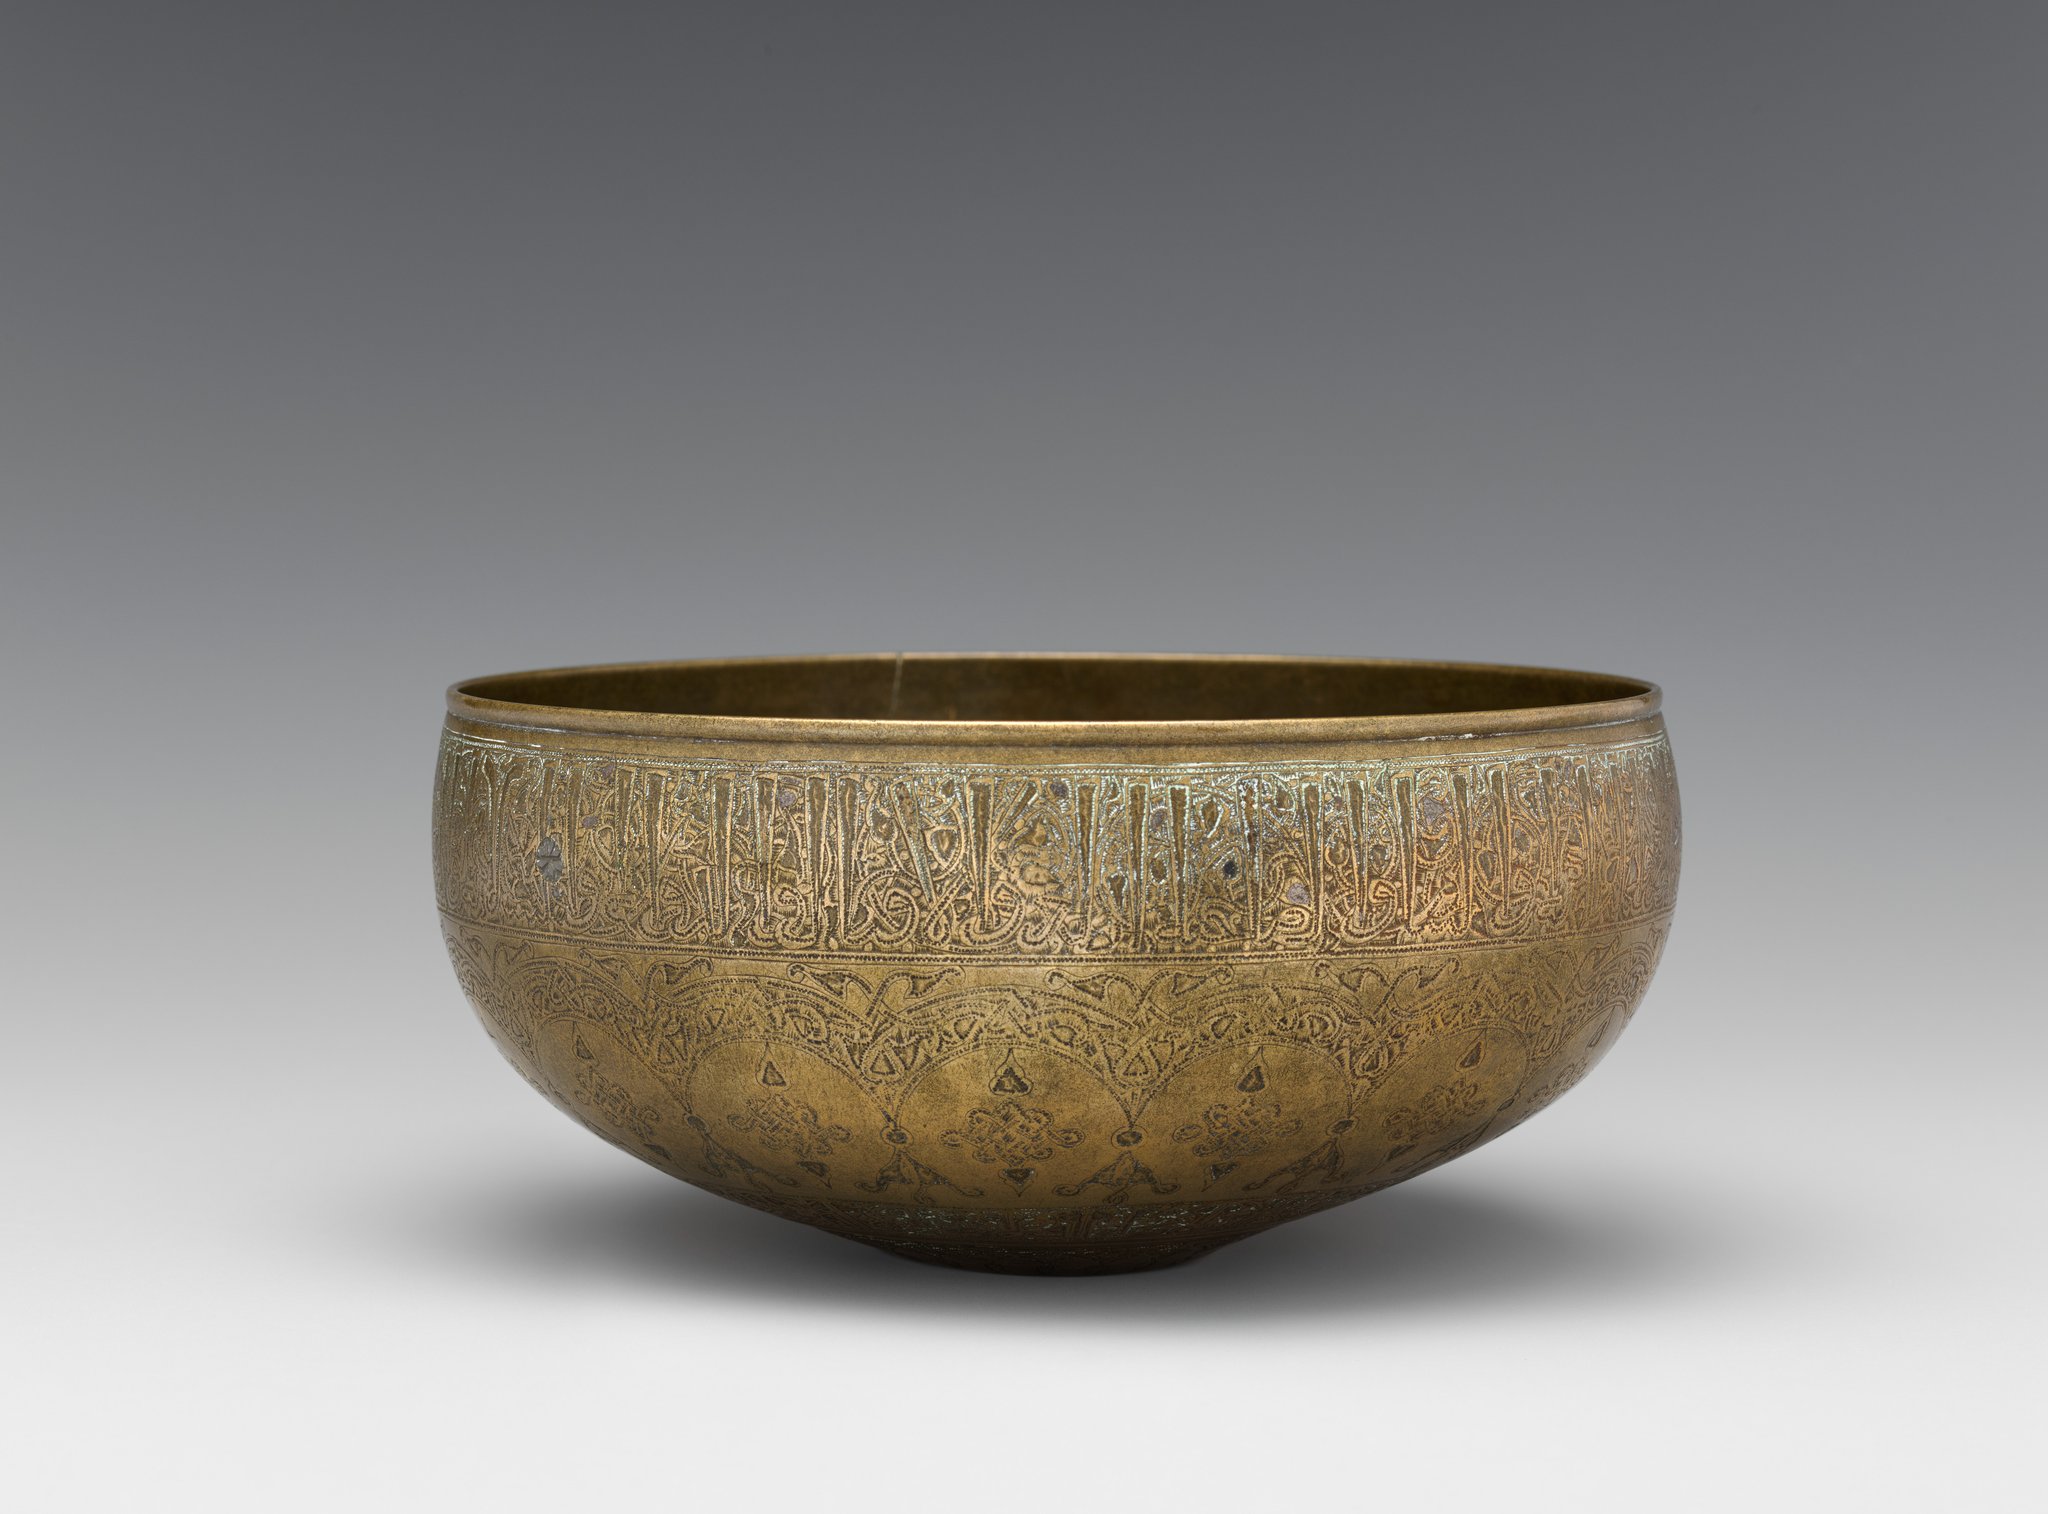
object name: bowl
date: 1201-1300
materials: bronze, silver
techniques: engraving, inlay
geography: iran